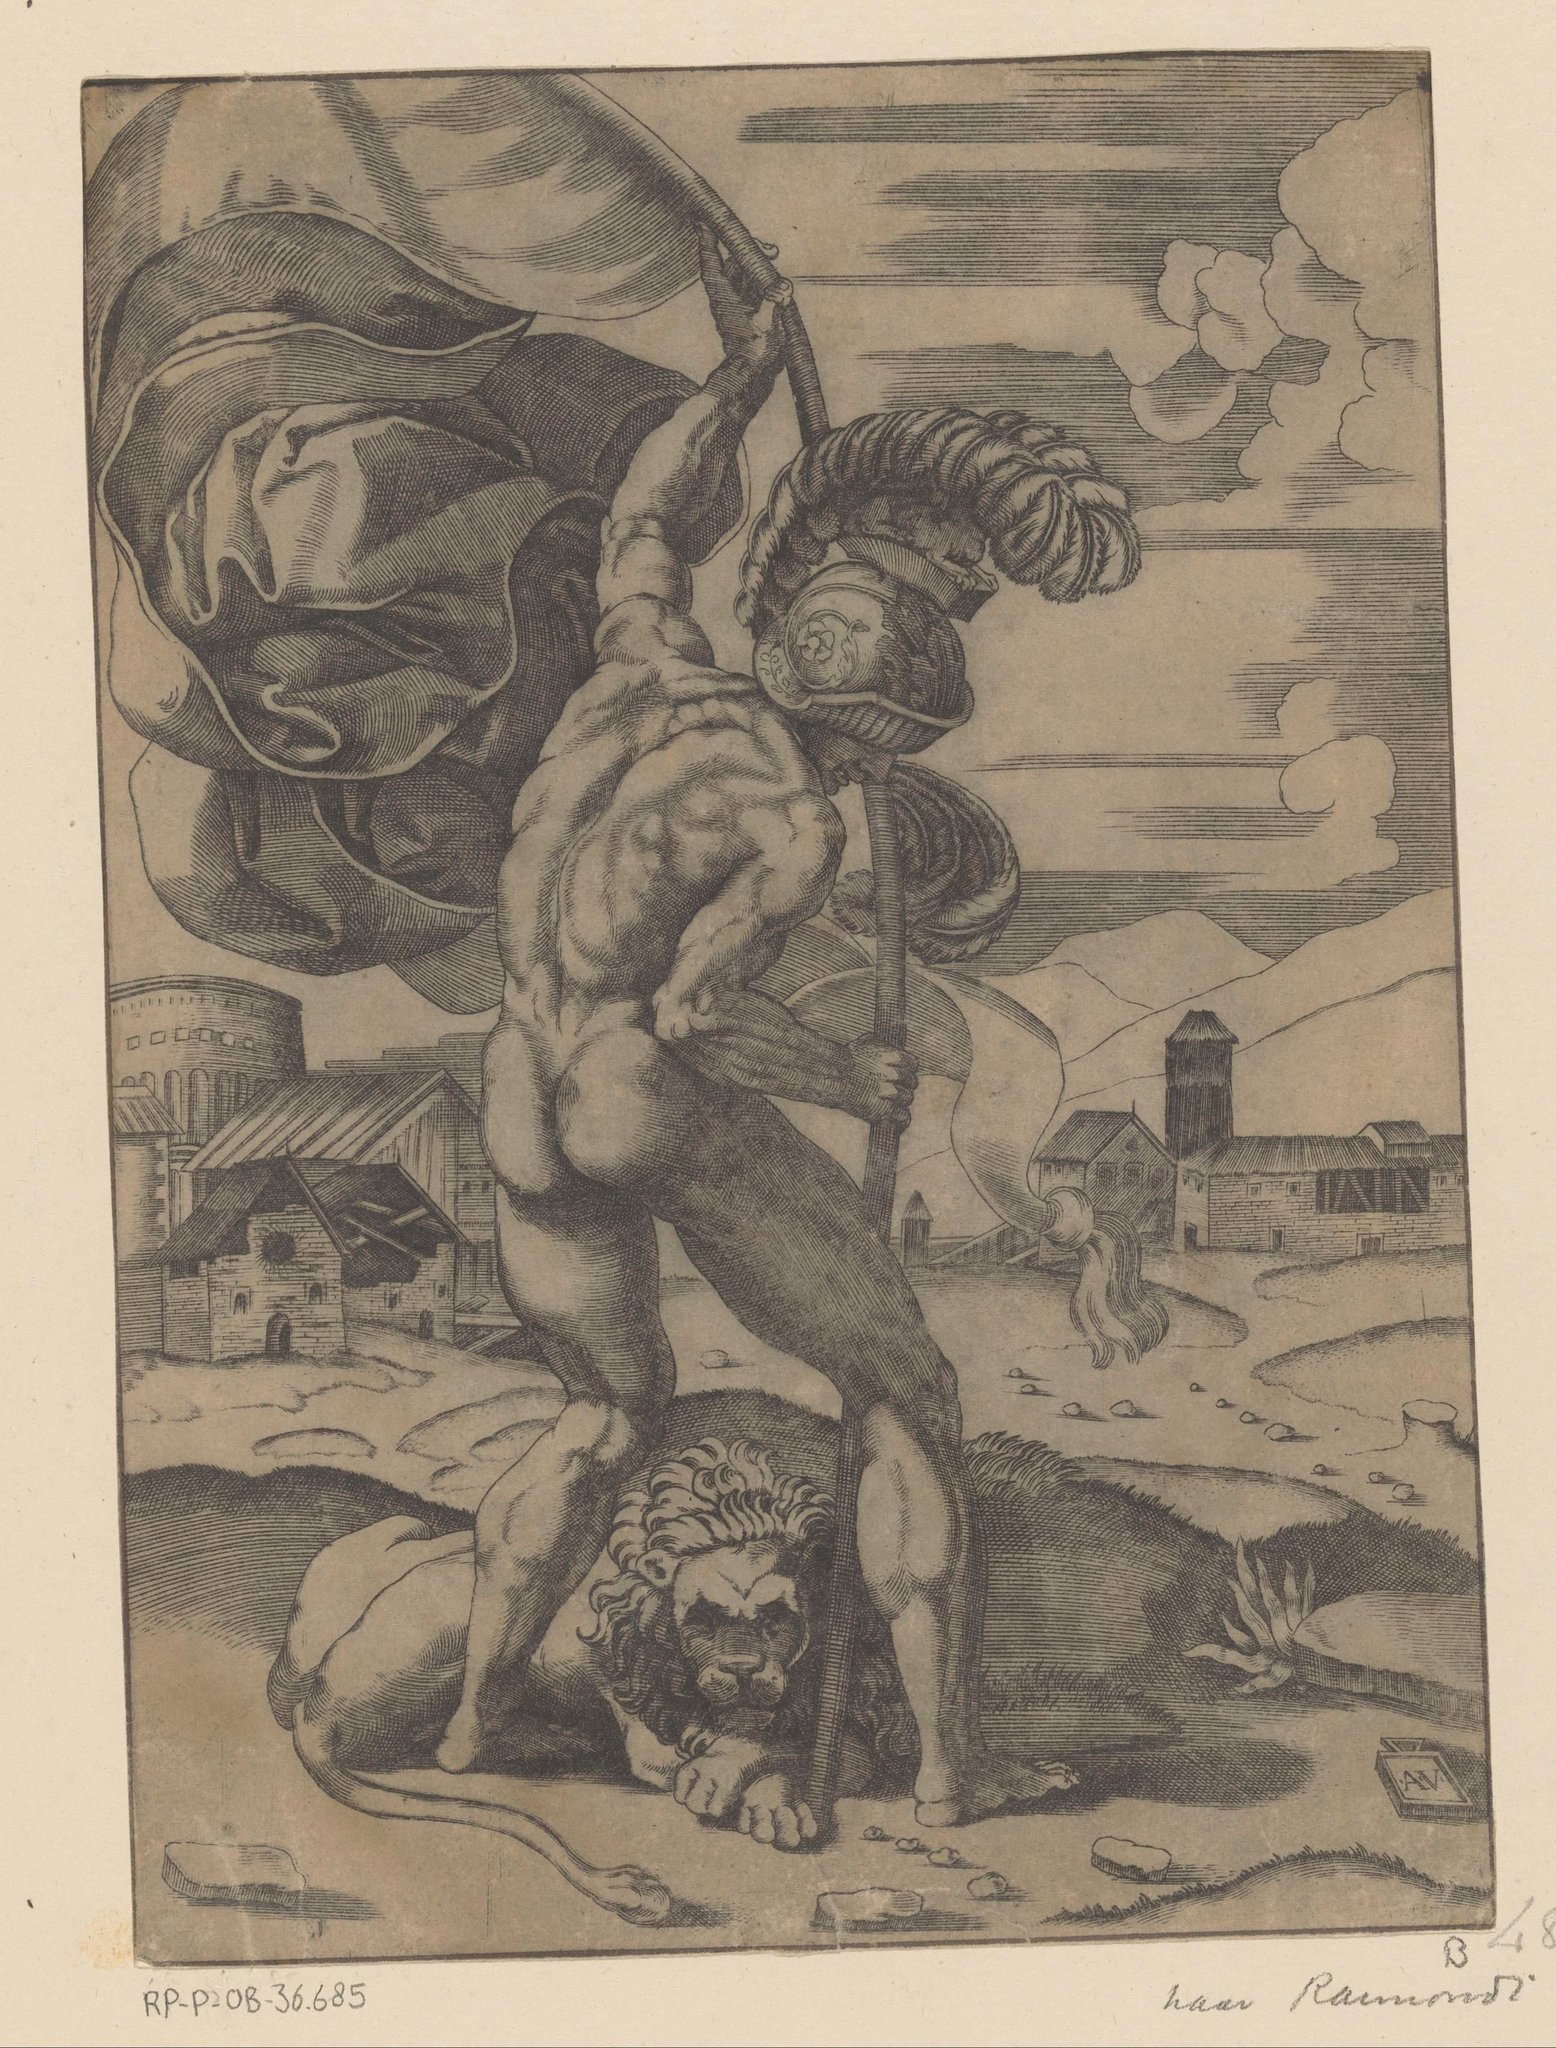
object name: print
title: Man met een vlag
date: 1500-1536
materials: paper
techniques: engraving, etching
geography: italy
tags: city-view, and landscape with man-made constructions, standard-bearer, flag-bearer, beasts of prey, predatory animals: lion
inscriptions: collector's mark: Lugt 240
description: Een naakte man plant een wapperende vlag in de grond. Aan zijn voeten een leeuw. Op de achtergrond een landschap met bebouwing.